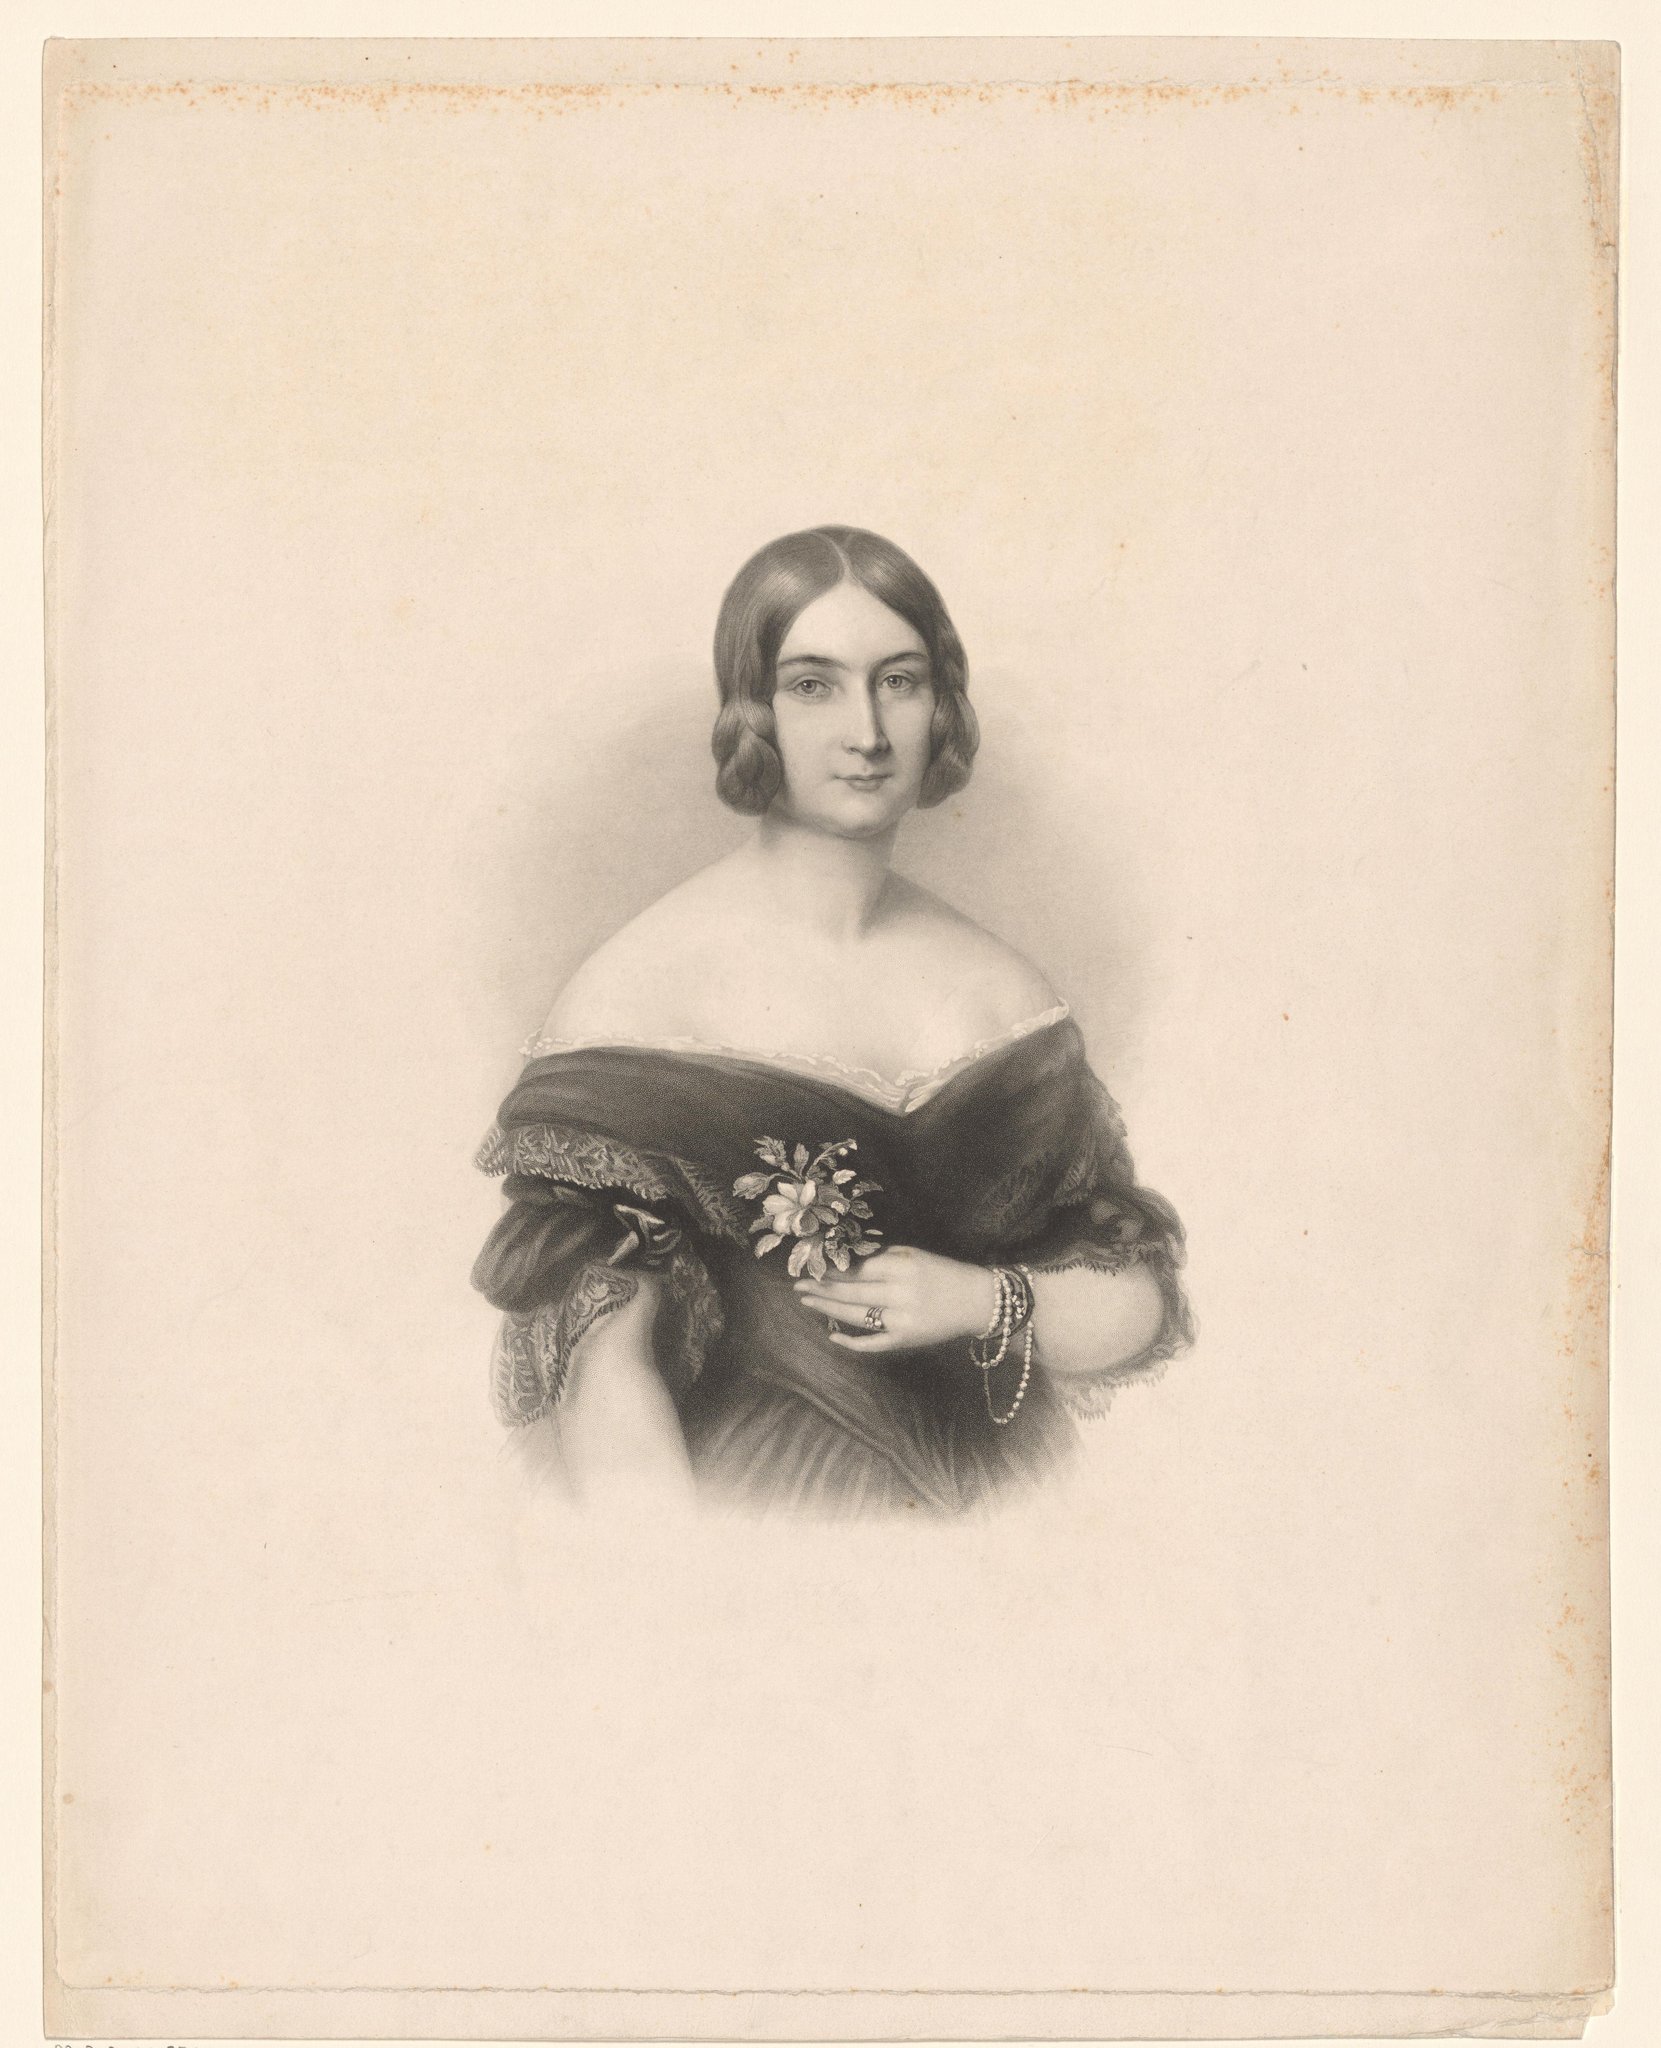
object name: print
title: Portret van Augusta van Hessen-Kassel, hertogin van Cambridge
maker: charles wentworth wass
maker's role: print maker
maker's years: 1822-1905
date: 1842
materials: paper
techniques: engraving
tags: london, historical persons - bb - woman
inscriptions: collector's mark: Lugt 2228